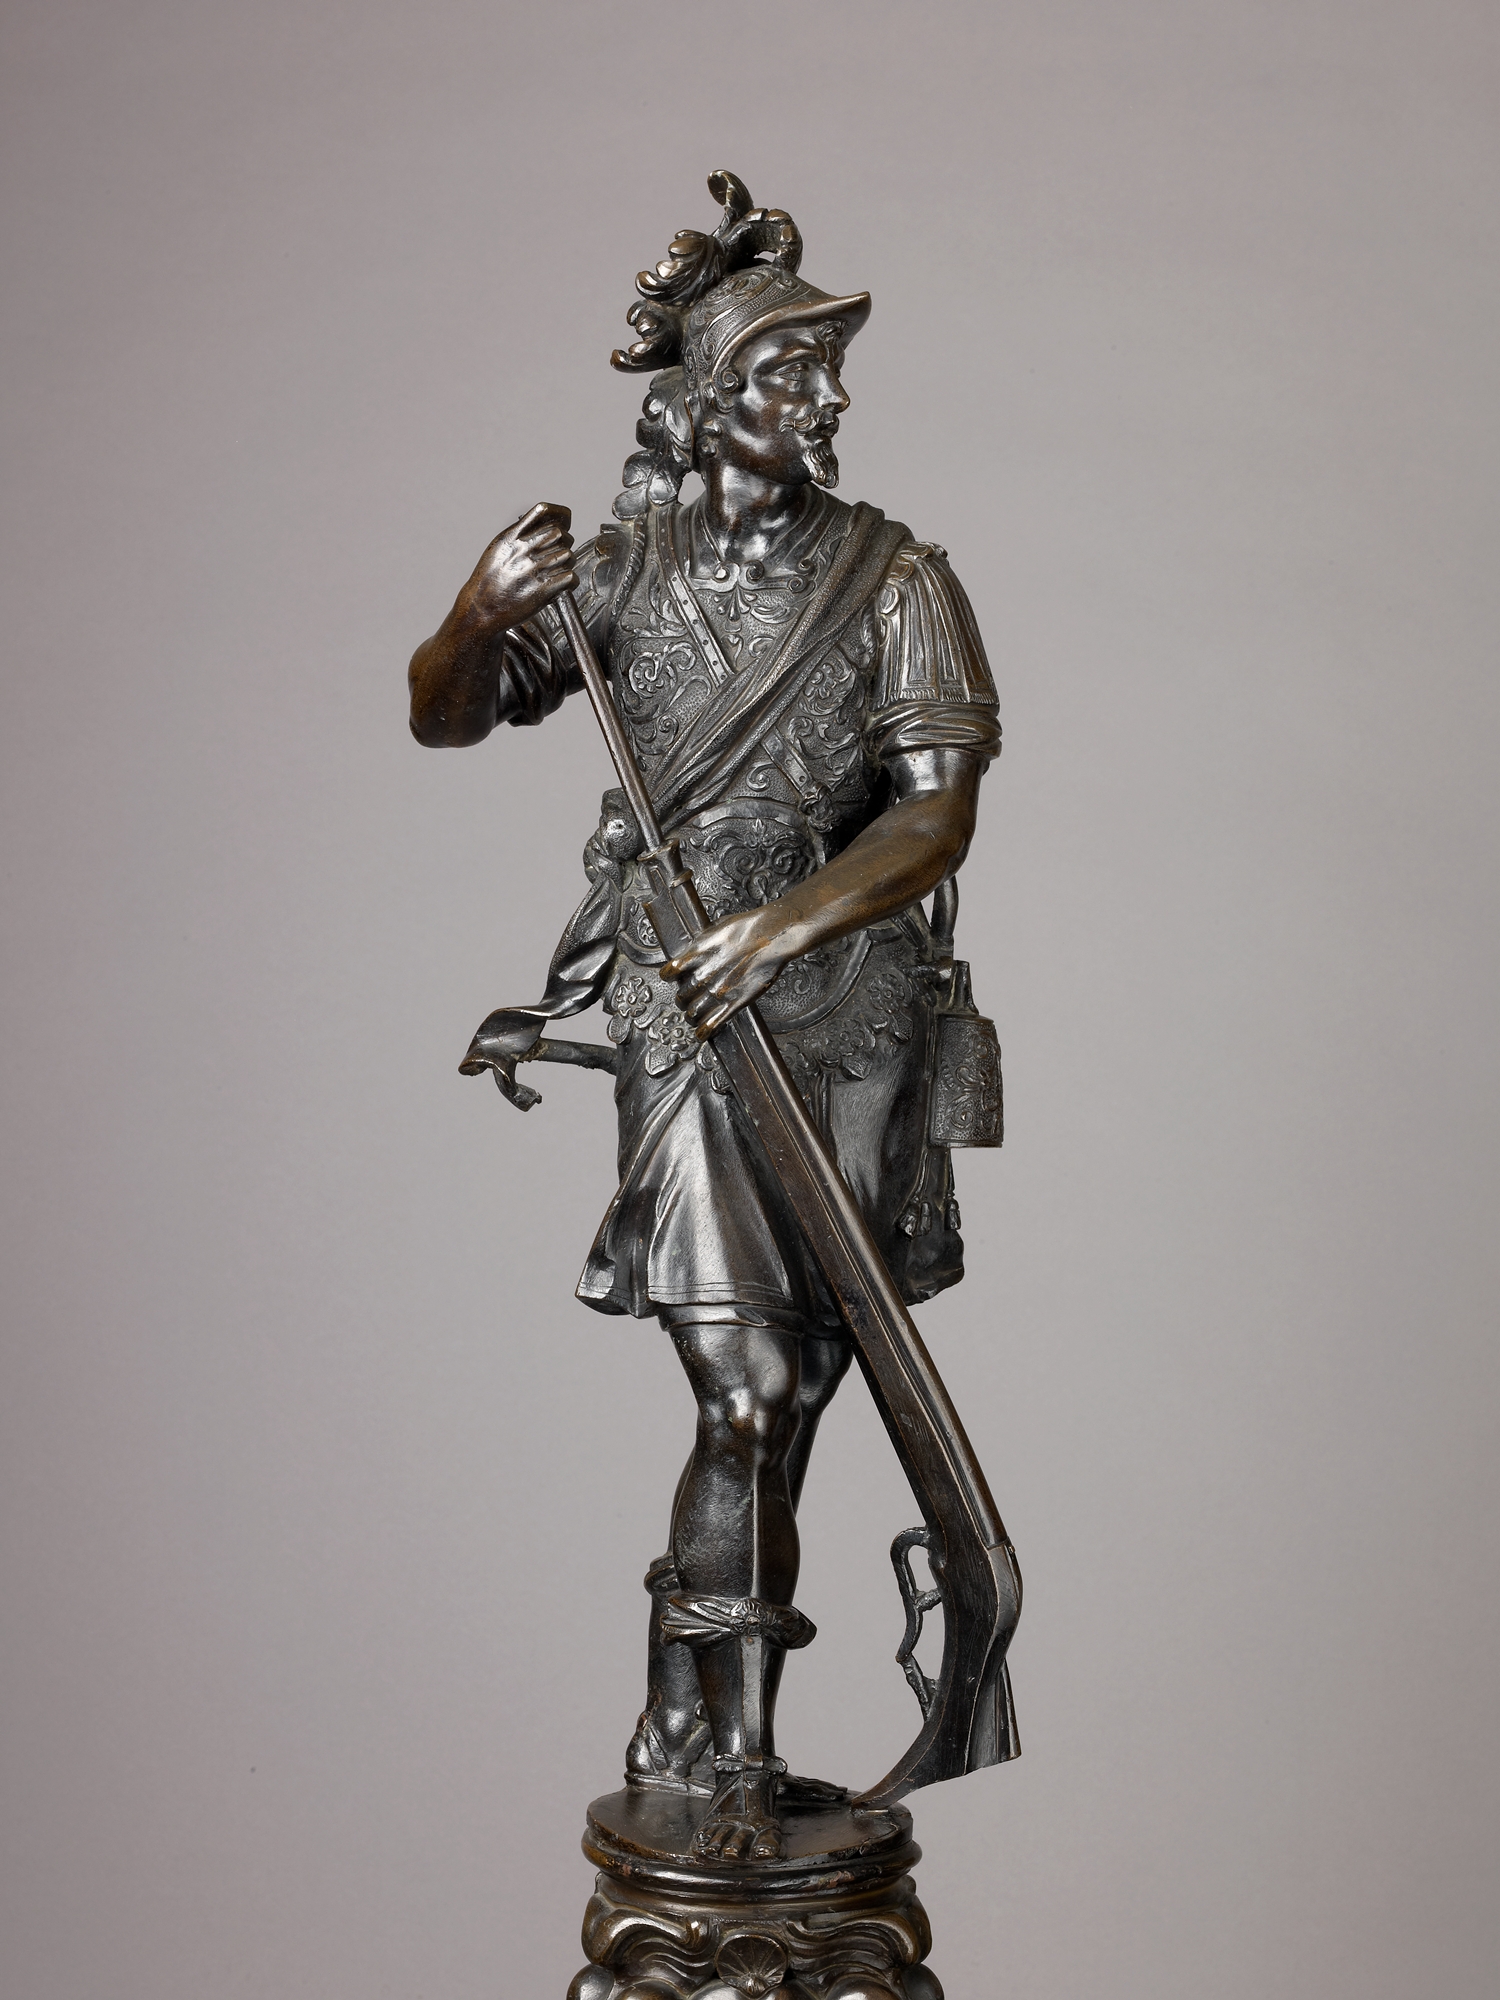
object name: andiron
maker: niccolò roccatagliata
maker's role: artist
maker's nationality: italian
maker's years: 1593-1636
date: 1601-1700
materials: copper alloy, patina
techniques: casting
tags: firearms,men